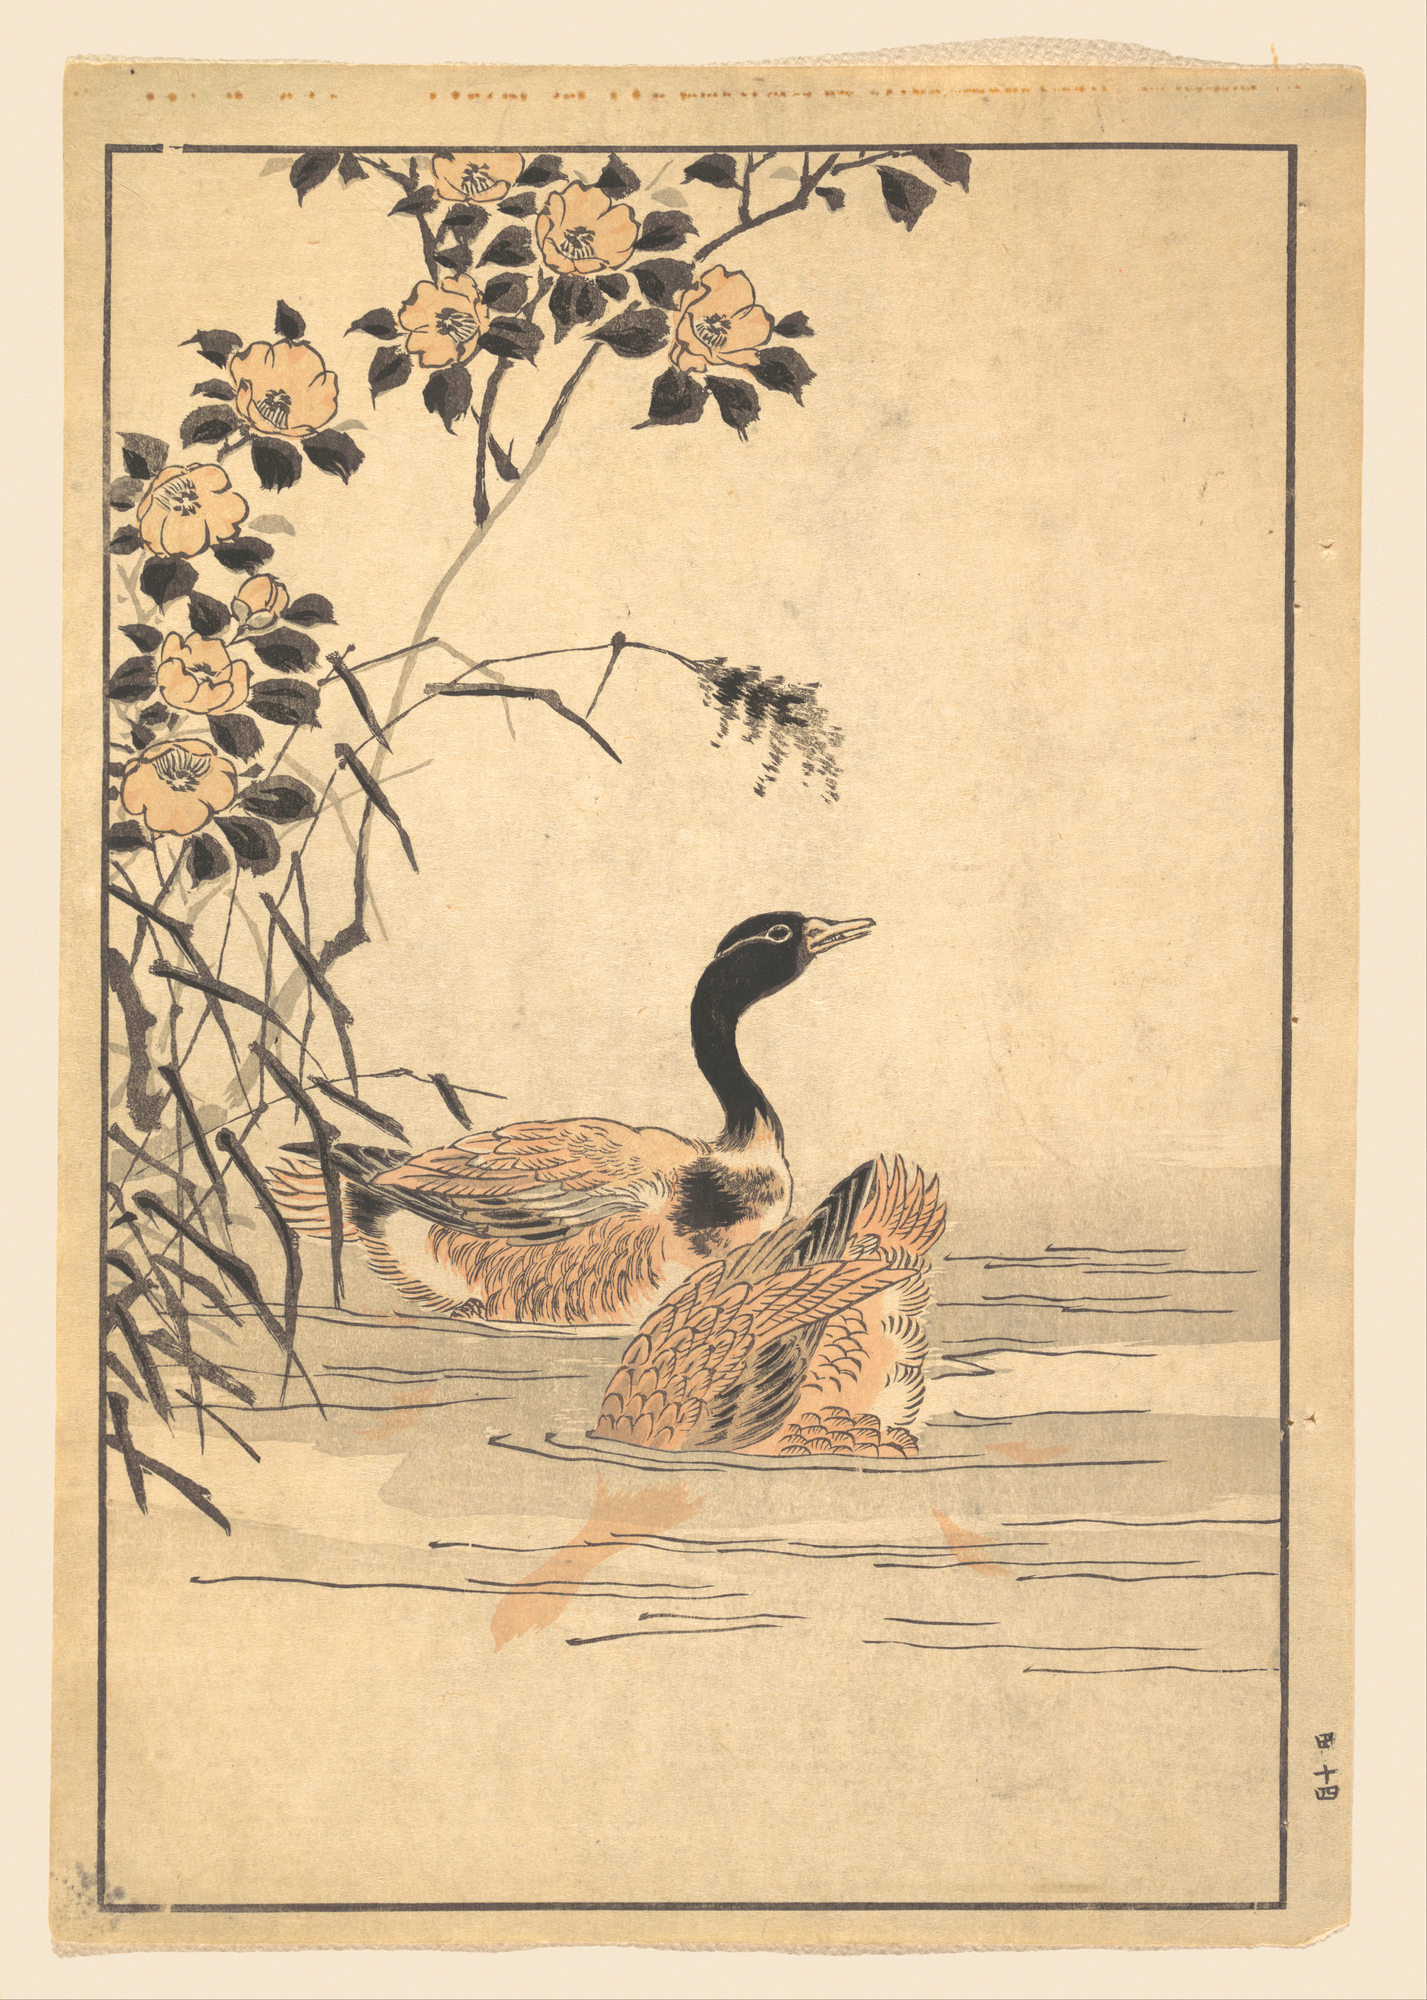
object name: print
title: A Pair of Geese with Camellias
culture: japanese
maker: unidentified artist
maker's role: artist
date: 1857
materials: ink, paper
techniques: woodblock print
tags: birds,flowers,plants